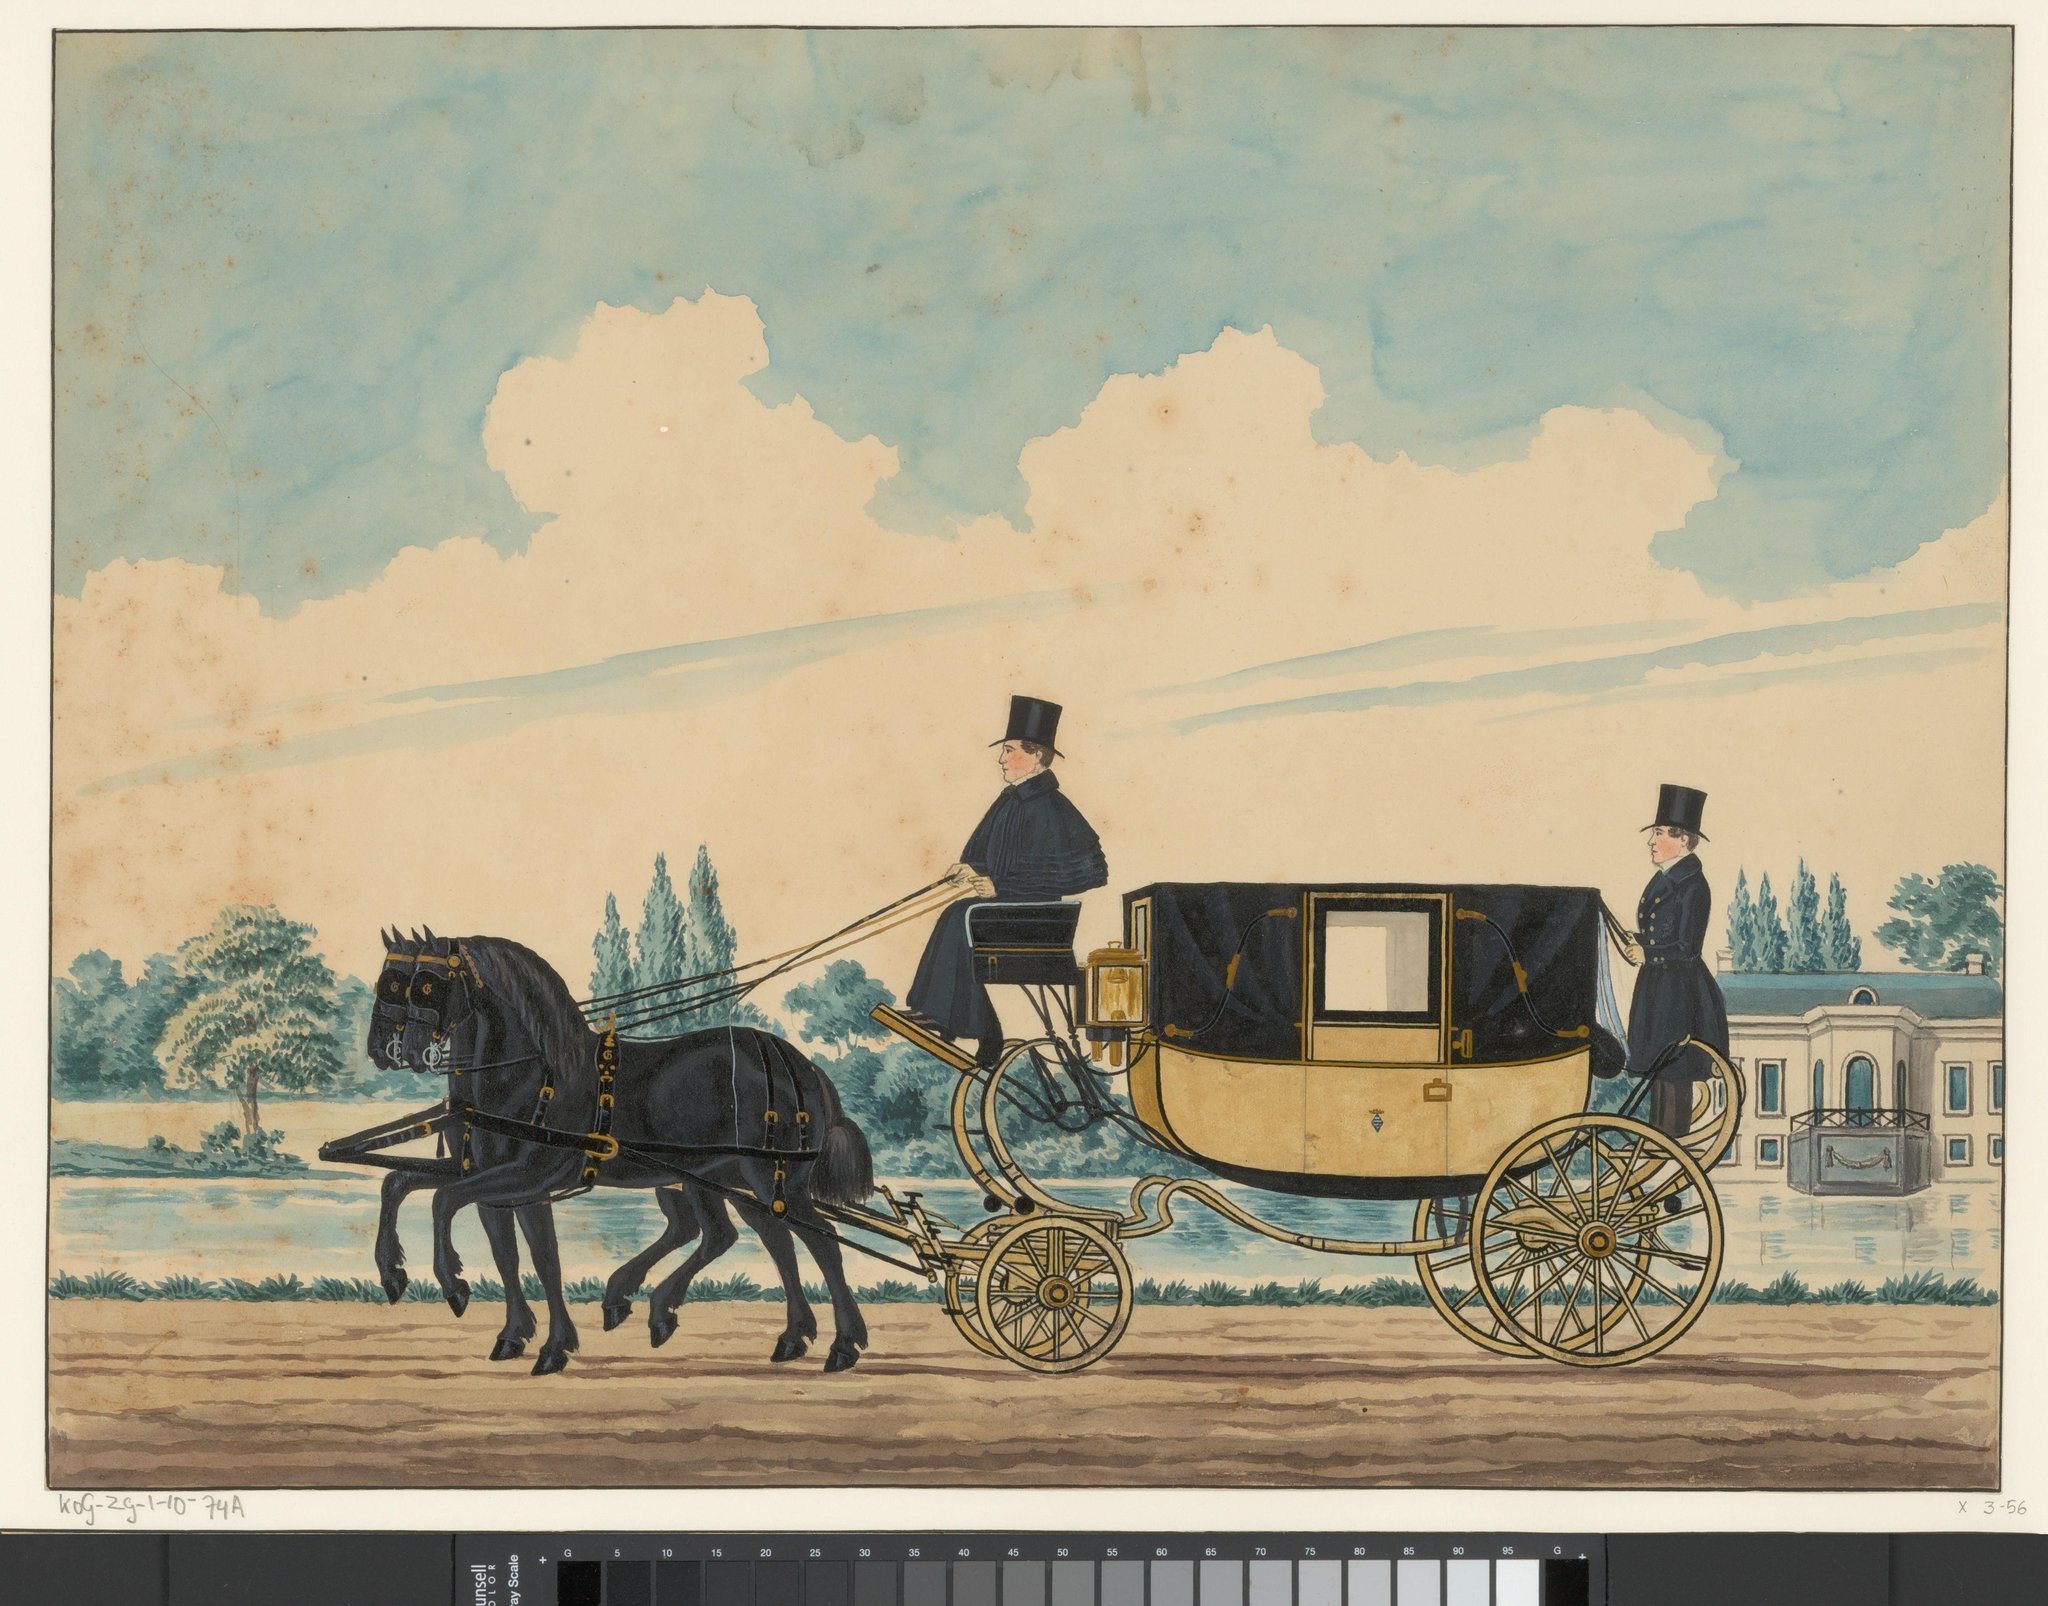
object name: drawing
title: Berline getrokken door twee paarden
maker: Anonymous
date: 1800-1899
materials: ink, paper, watercolor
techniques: brush, pen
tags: four-wheeled vehicle drawn by two animals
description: Berline getrokken door twee paarden rijdt langs een rivier. Onderwerpsrubrieken binnen de Atlas Zeden en Gewoonten: Handel, nijverheid en verkeer, Vervoermiddelen te land en te water, vervoermiddelen te land, Rijtuigen en Statiekarossen.